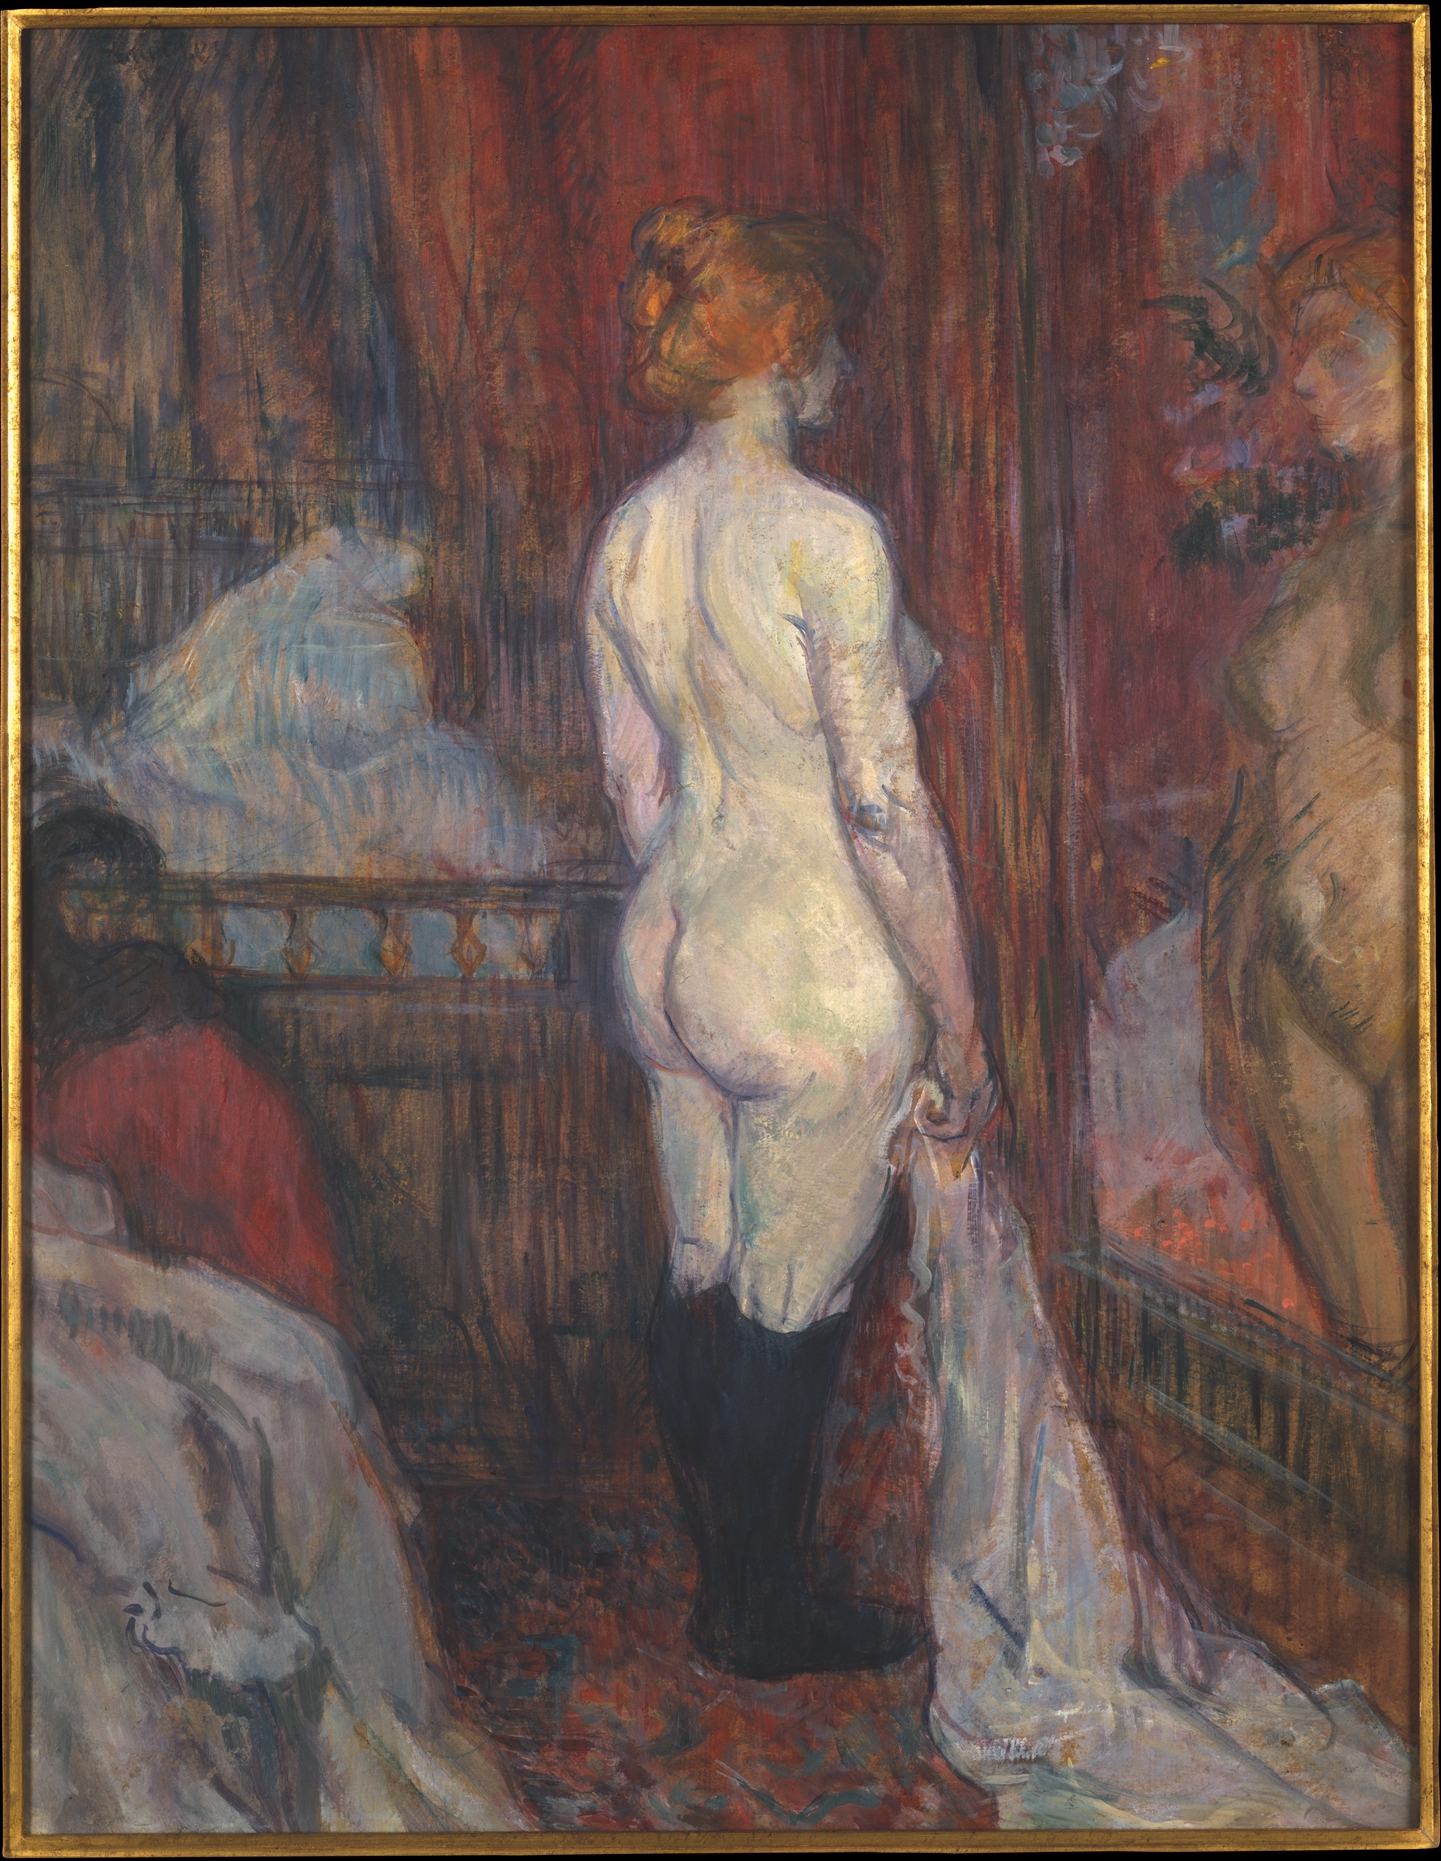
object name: painting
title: Woman before a Mirror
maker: henri de toulouse-lautrec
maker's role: artist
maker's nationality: french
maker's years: 1864-1901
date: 1897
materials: cardboard, oil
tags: female nudes,prostitutes,mirrors